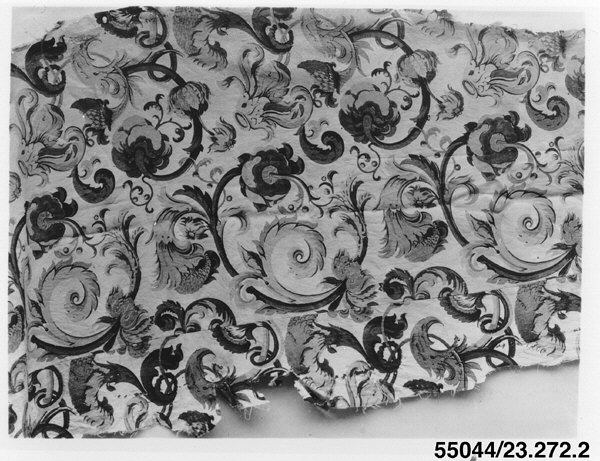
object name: delaine fragment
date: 1801-1900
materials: cotton, wool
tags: flowers